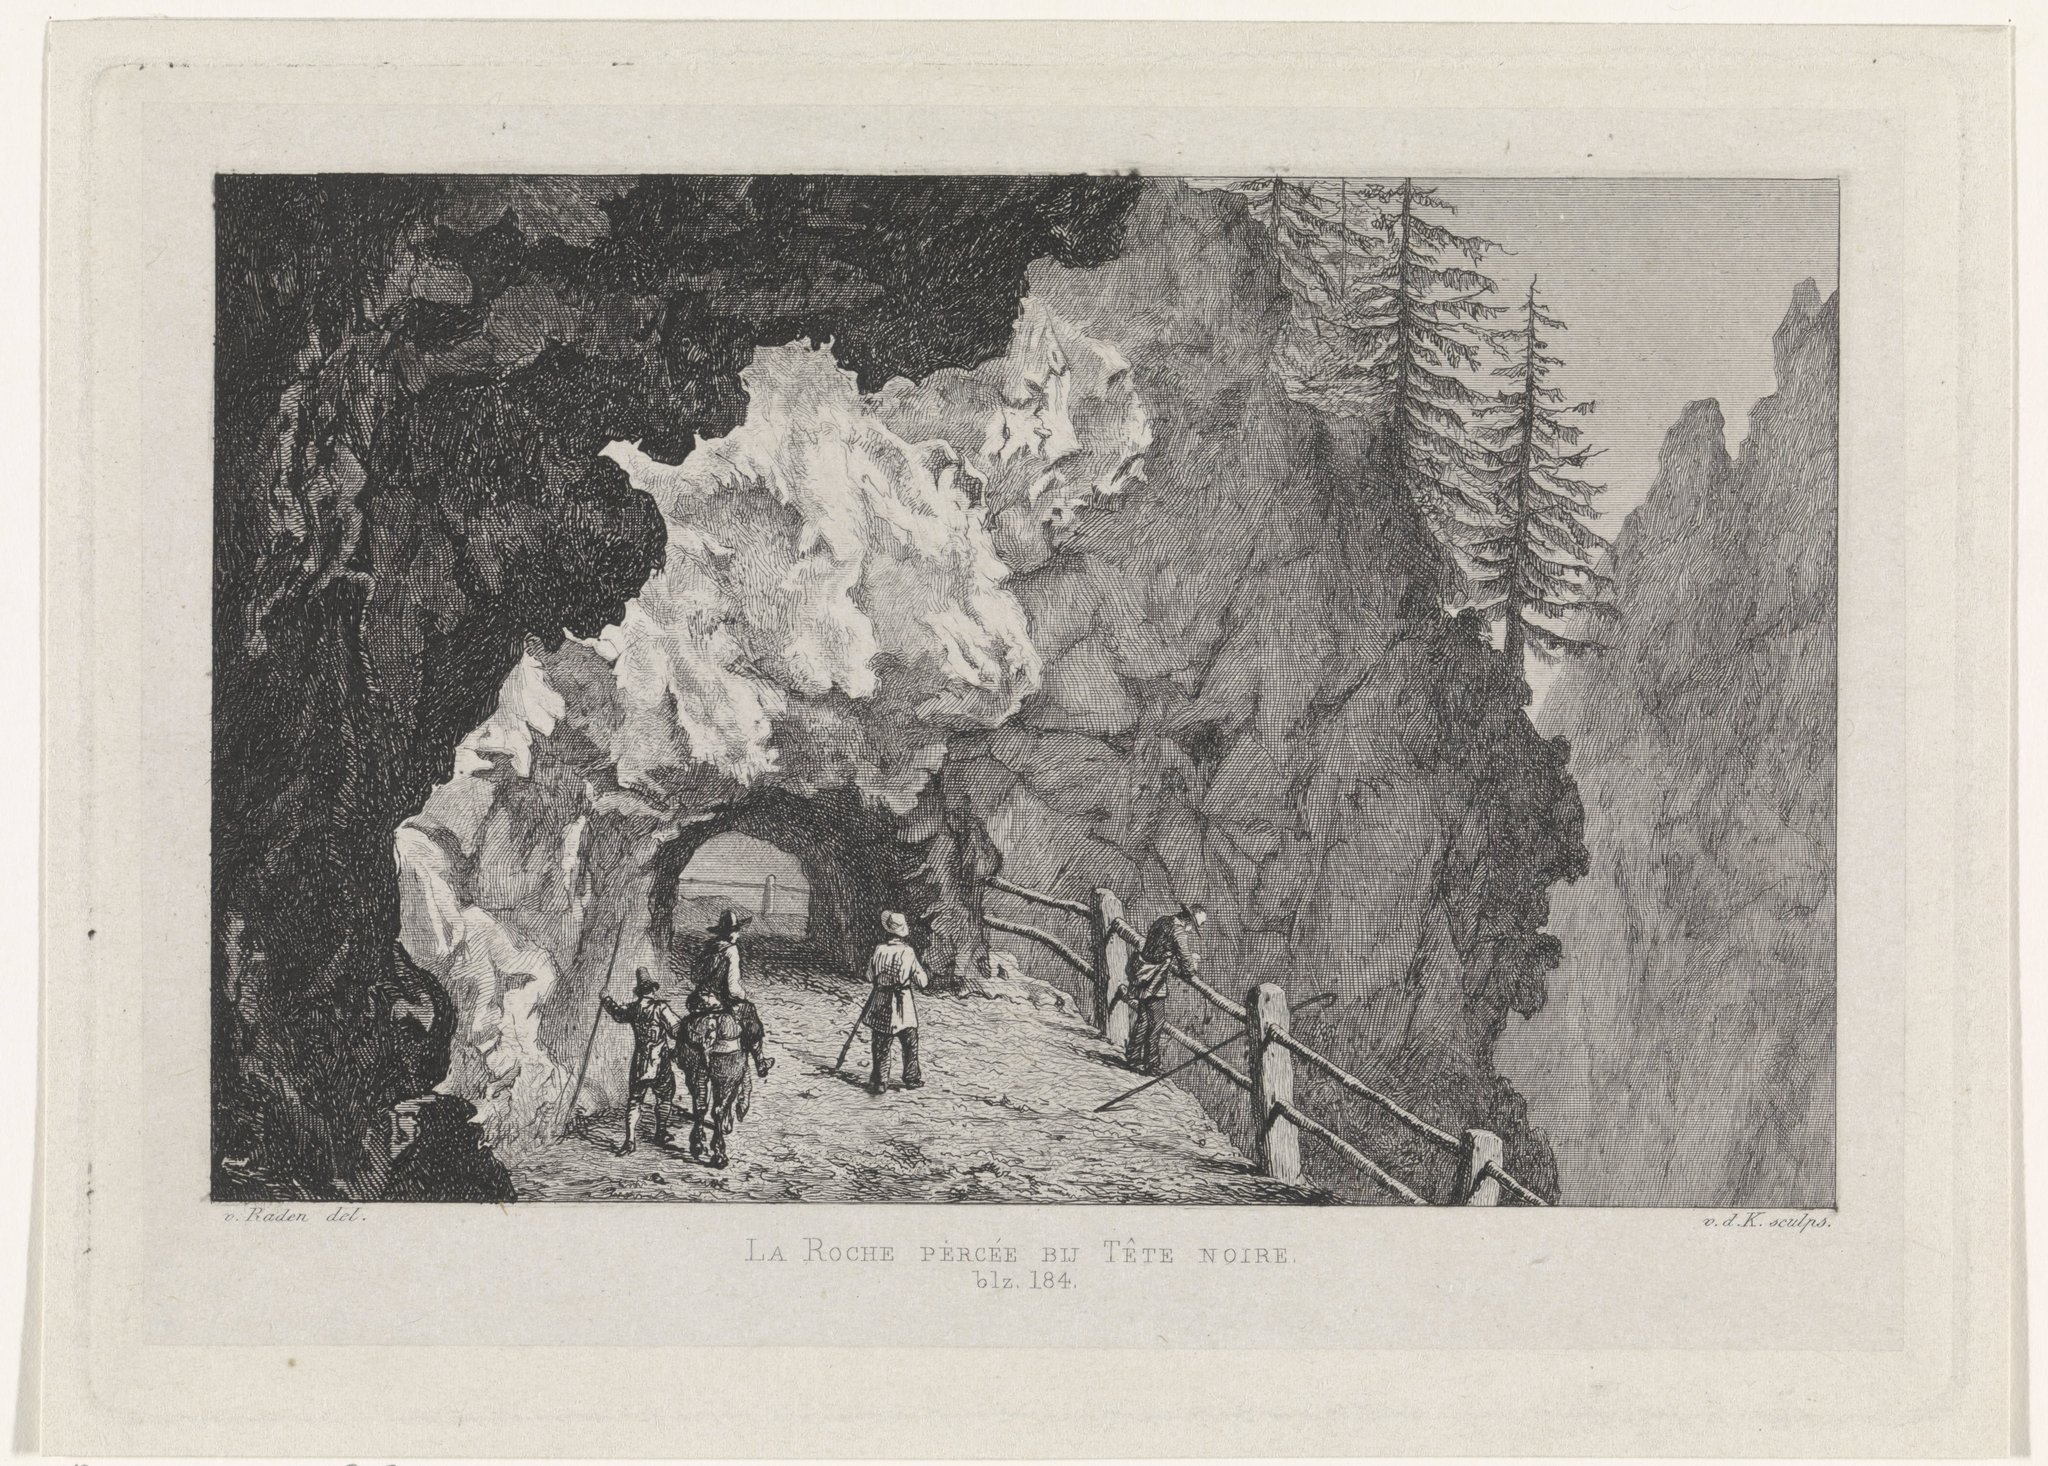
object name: print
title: La Roche percée bij Tête Noire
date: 1837-1885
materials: paper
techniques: drypoint, etching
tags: horse, 'en route', traveller under way, rocks, mountains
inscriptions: collector's mark: Lugt 2228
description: Gezicht op een doorgang in de rotsen, met op het bergpad drie voetgangers en een ruiter. Links van de weg een rotswand en rechts een afgrond waar een van de mannen naar beneden staat te kijken. In de marge de titel en: blz. 184.